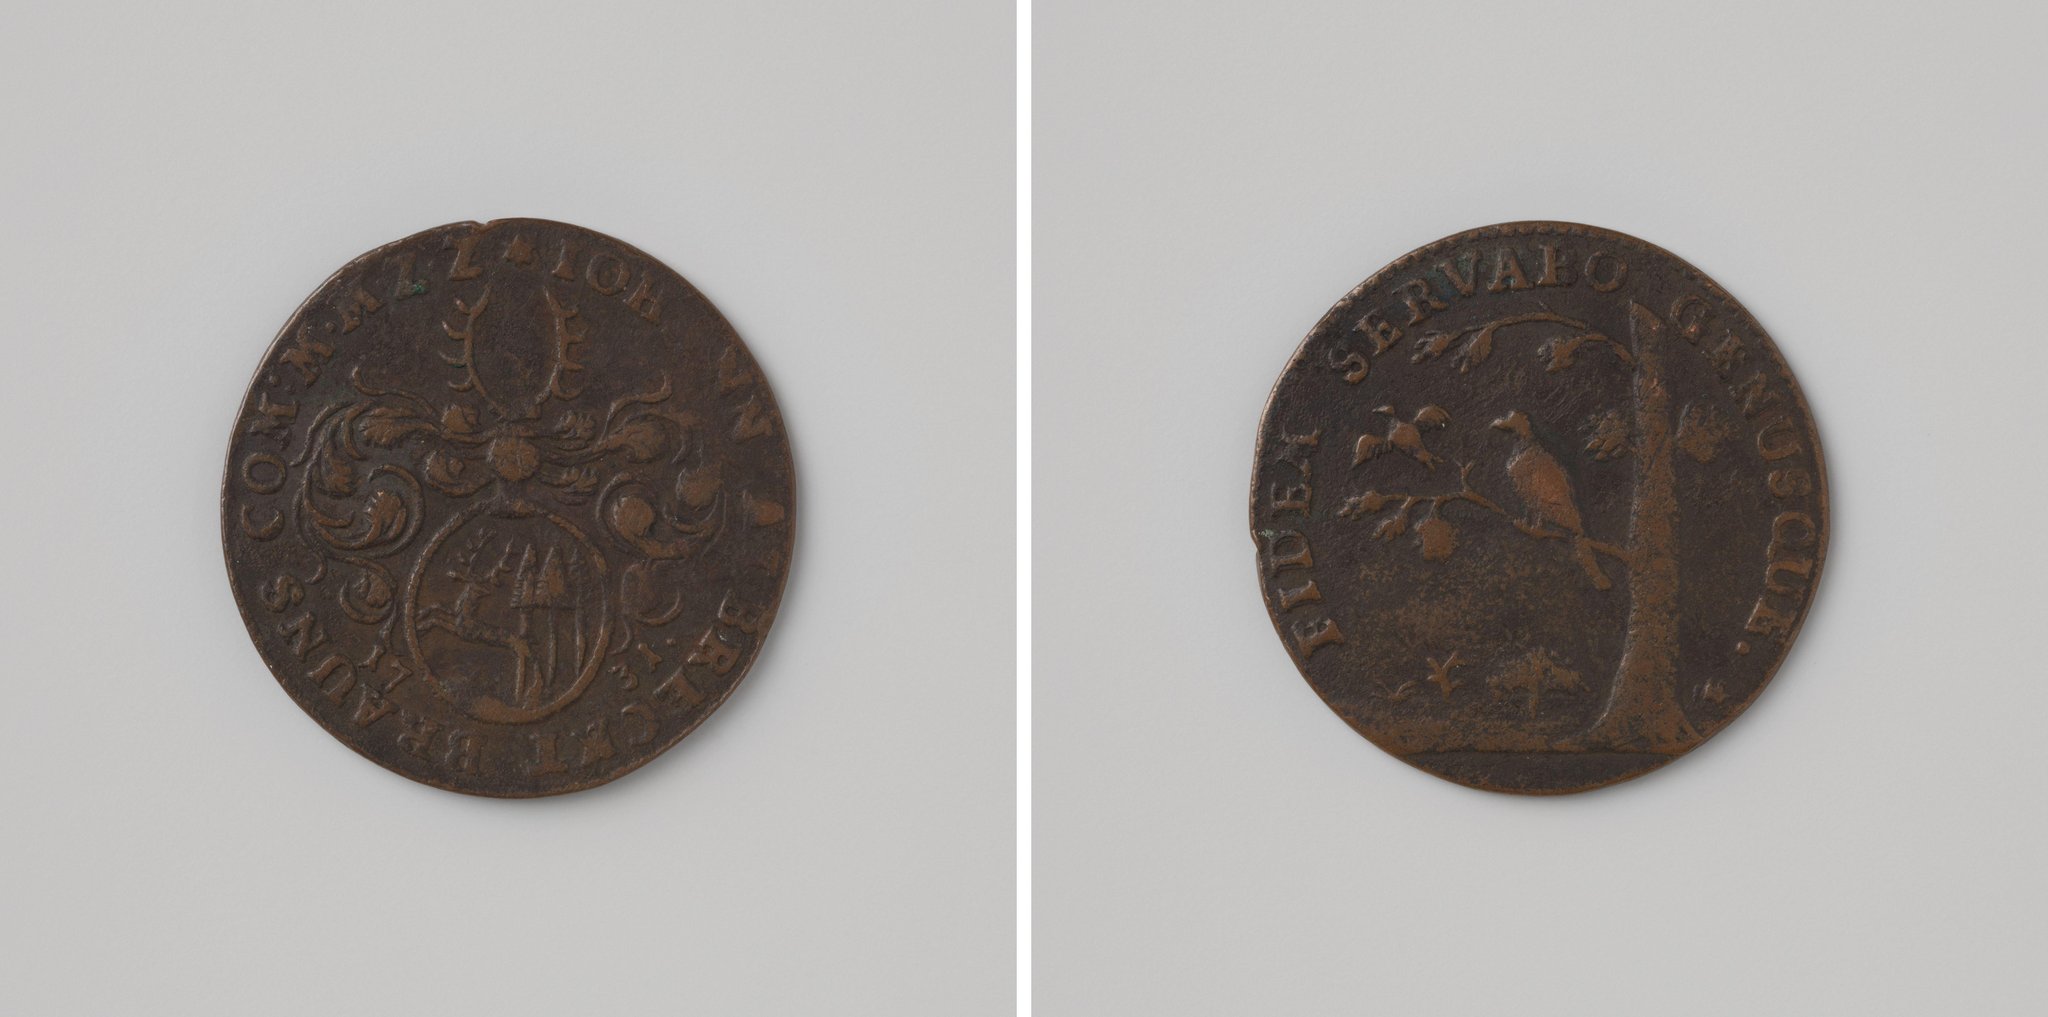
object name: adrespenning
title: Johann Albrecht Braunsy, muntmeester te Zellerfeld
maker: Anonymous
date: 1731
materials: copper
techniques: striking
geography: clausthal-zellerfeld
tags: johann albrecht braunsy, clausthal-zellerfeld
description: Koperen penning. Voorzijde: gehelmd wapenschild boven jaartal binnen omschrift. Keerzijde: boom, waarin vogel zit, terwijl tweede vogel wegvliegt binnen omschrift